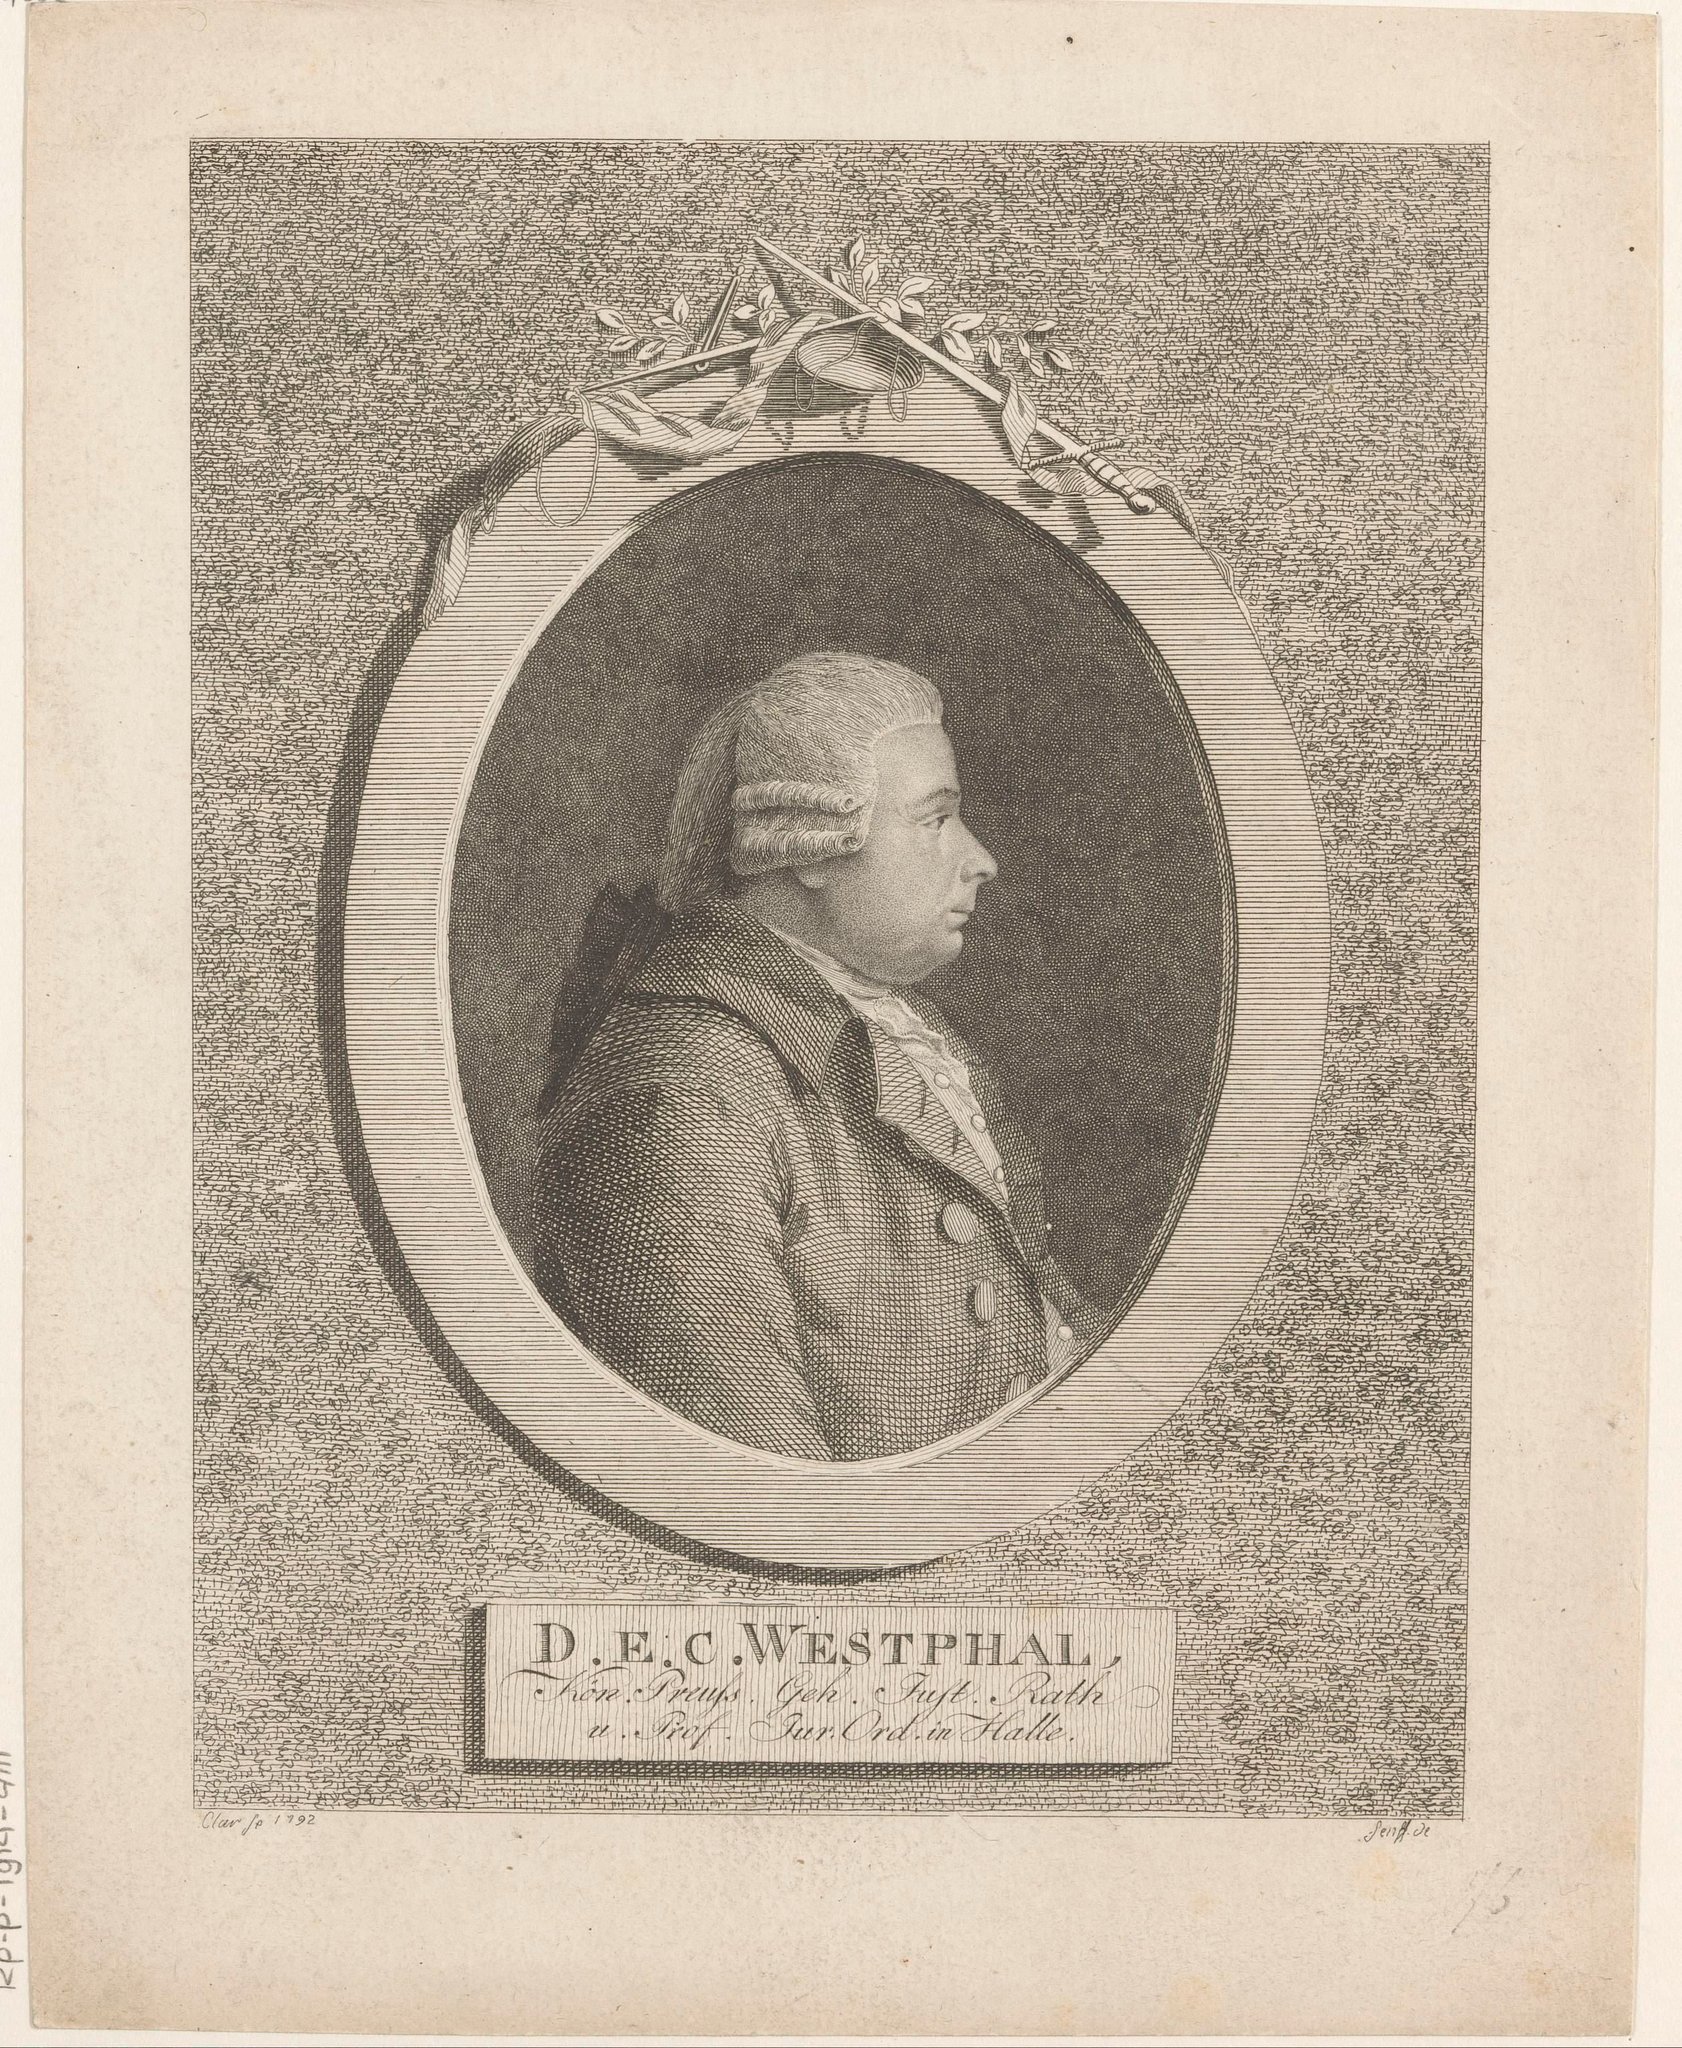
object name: print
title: Portret van Ernst Christian Westphal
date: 1792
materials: paper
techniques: etching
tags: ornament ~ medallion, historical persons, justitia (justice) as roman personification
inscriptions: collector's mark: Lugt 2228